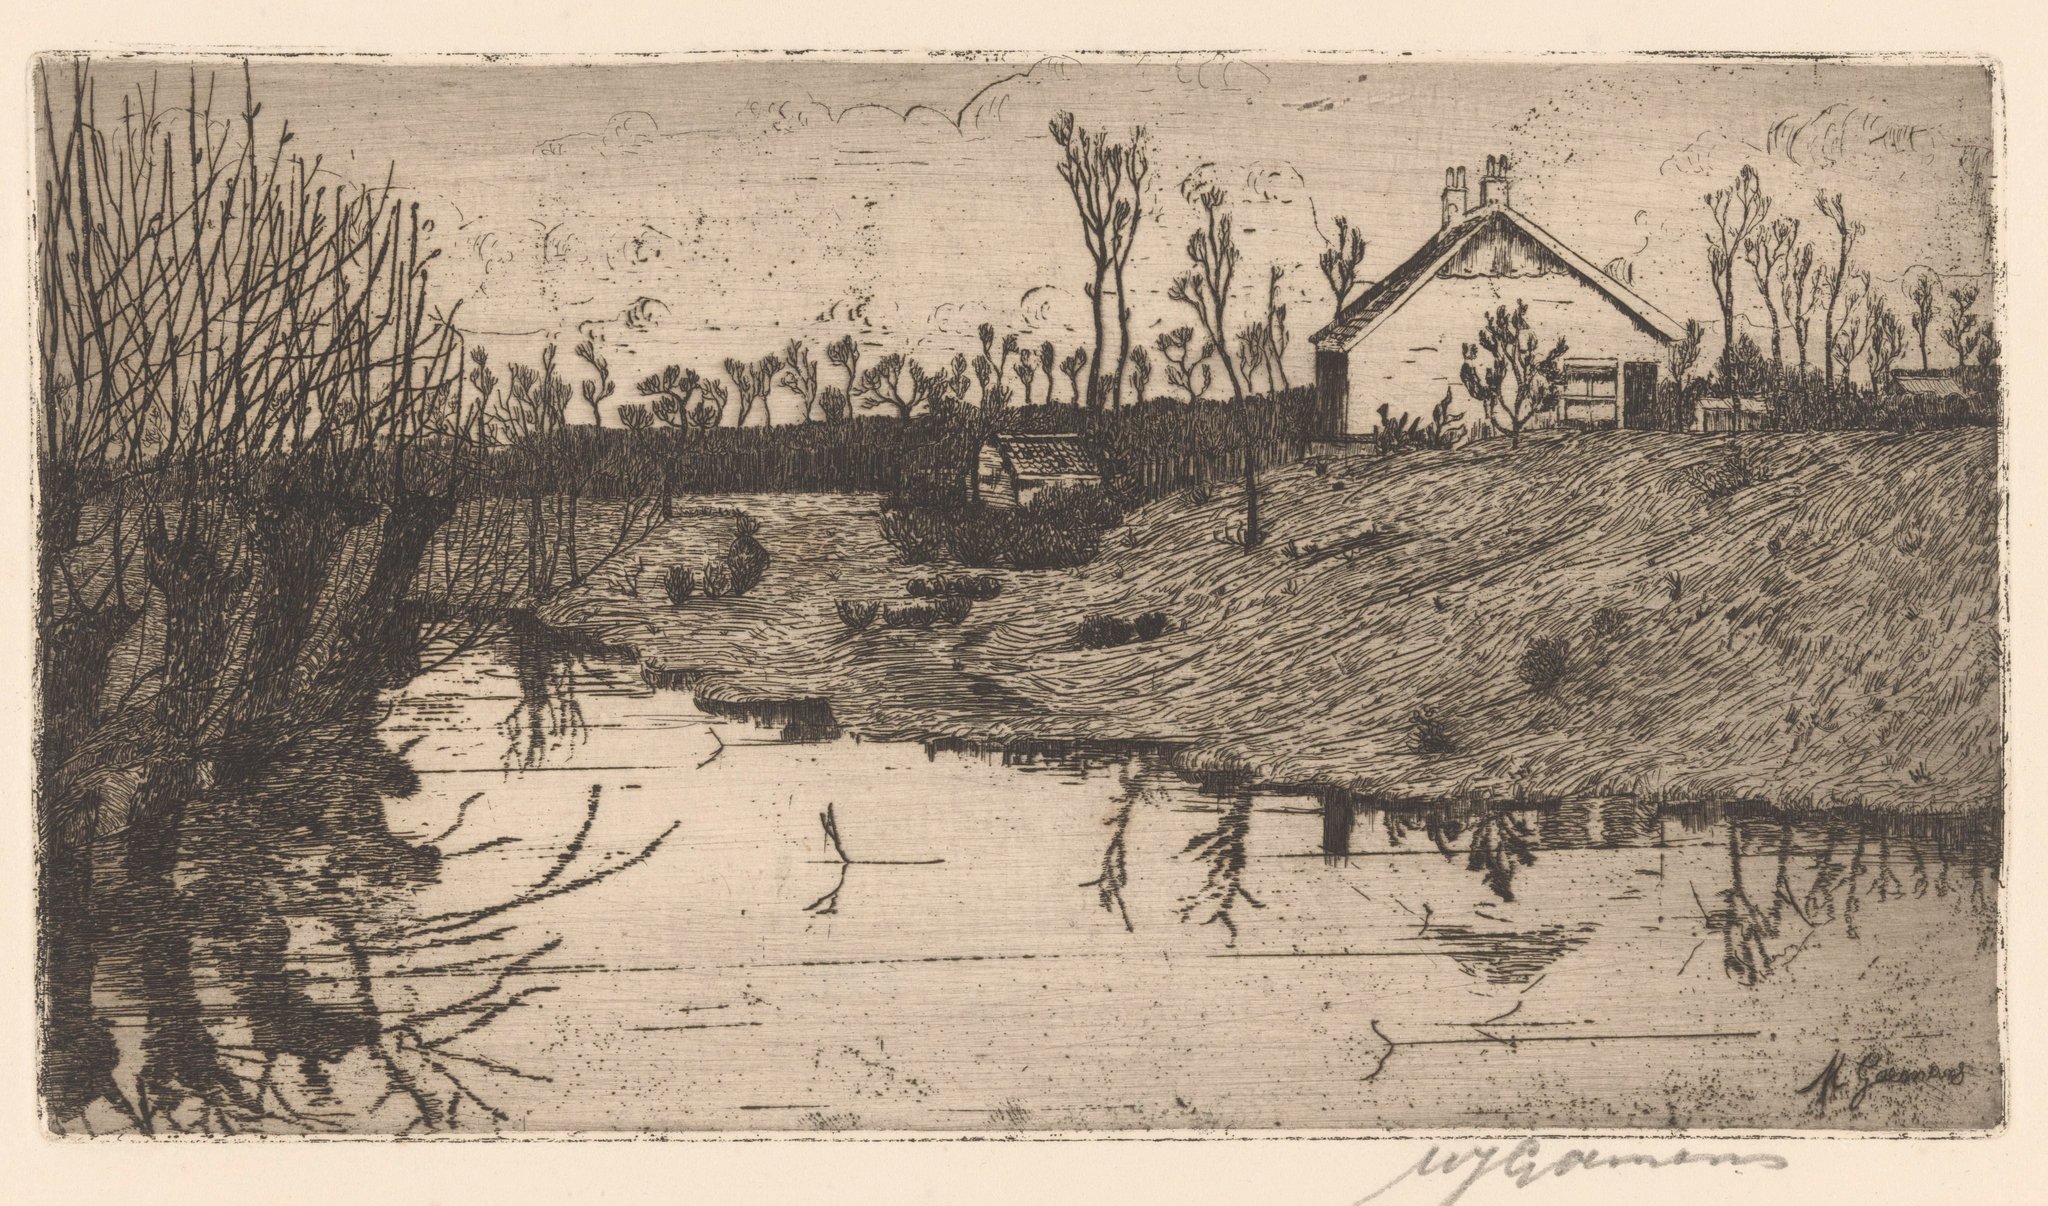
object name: print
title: Huis aan een sloot met knotwilgen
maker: maria johanna goemans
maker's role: draughtsman, print maker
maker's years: 1877-1936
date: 1887-1936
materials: paper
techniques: etching, intaglio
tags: trees: willow, small canal, ditch, farm or solitary house in landscape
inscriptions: collector's mark: Lugt 2228